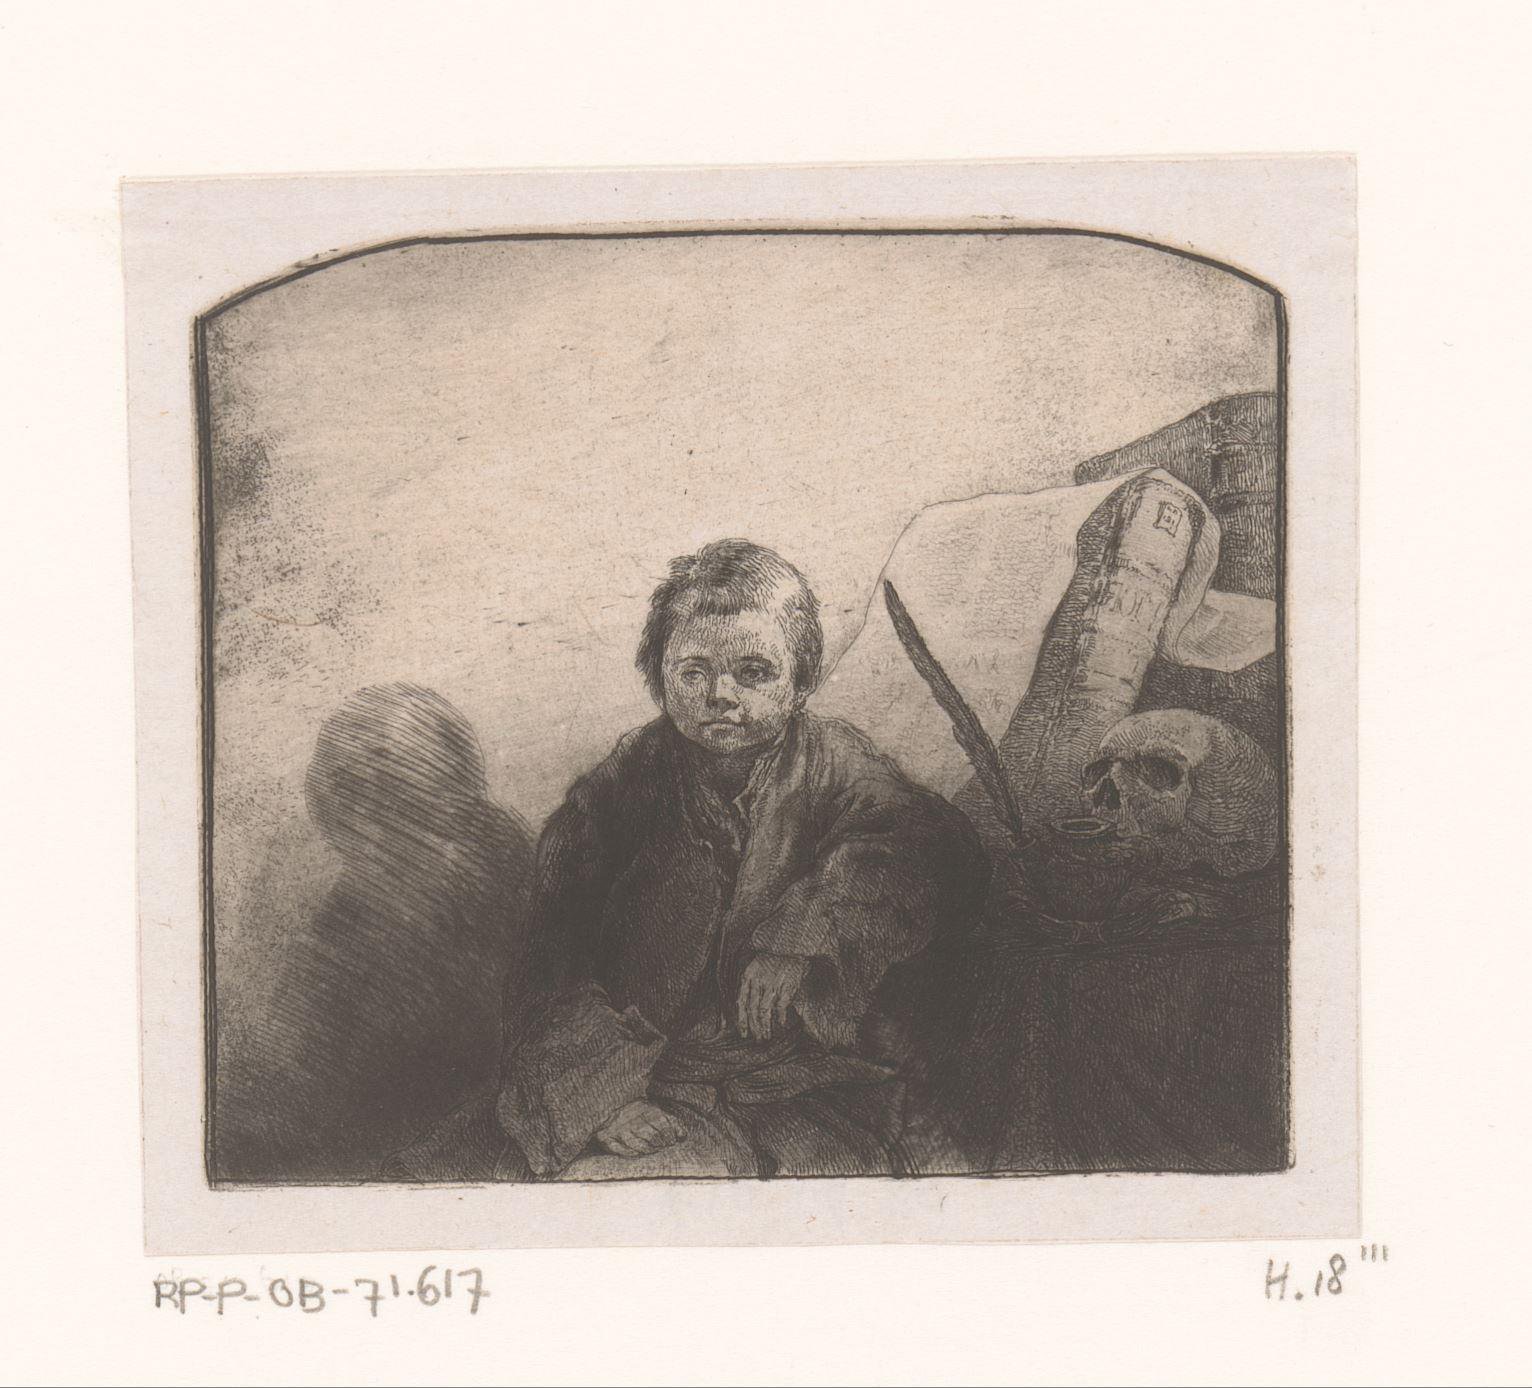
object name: print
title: Zittende jongen bij een tafel met boek en schedel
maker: jean pierre norblin de la gourdaine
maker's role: print maker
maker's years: 1745-1830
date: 1755-1830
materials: paper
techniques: etching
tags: scholar, philosopher, child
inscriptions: collector's mark: Lugt 2228